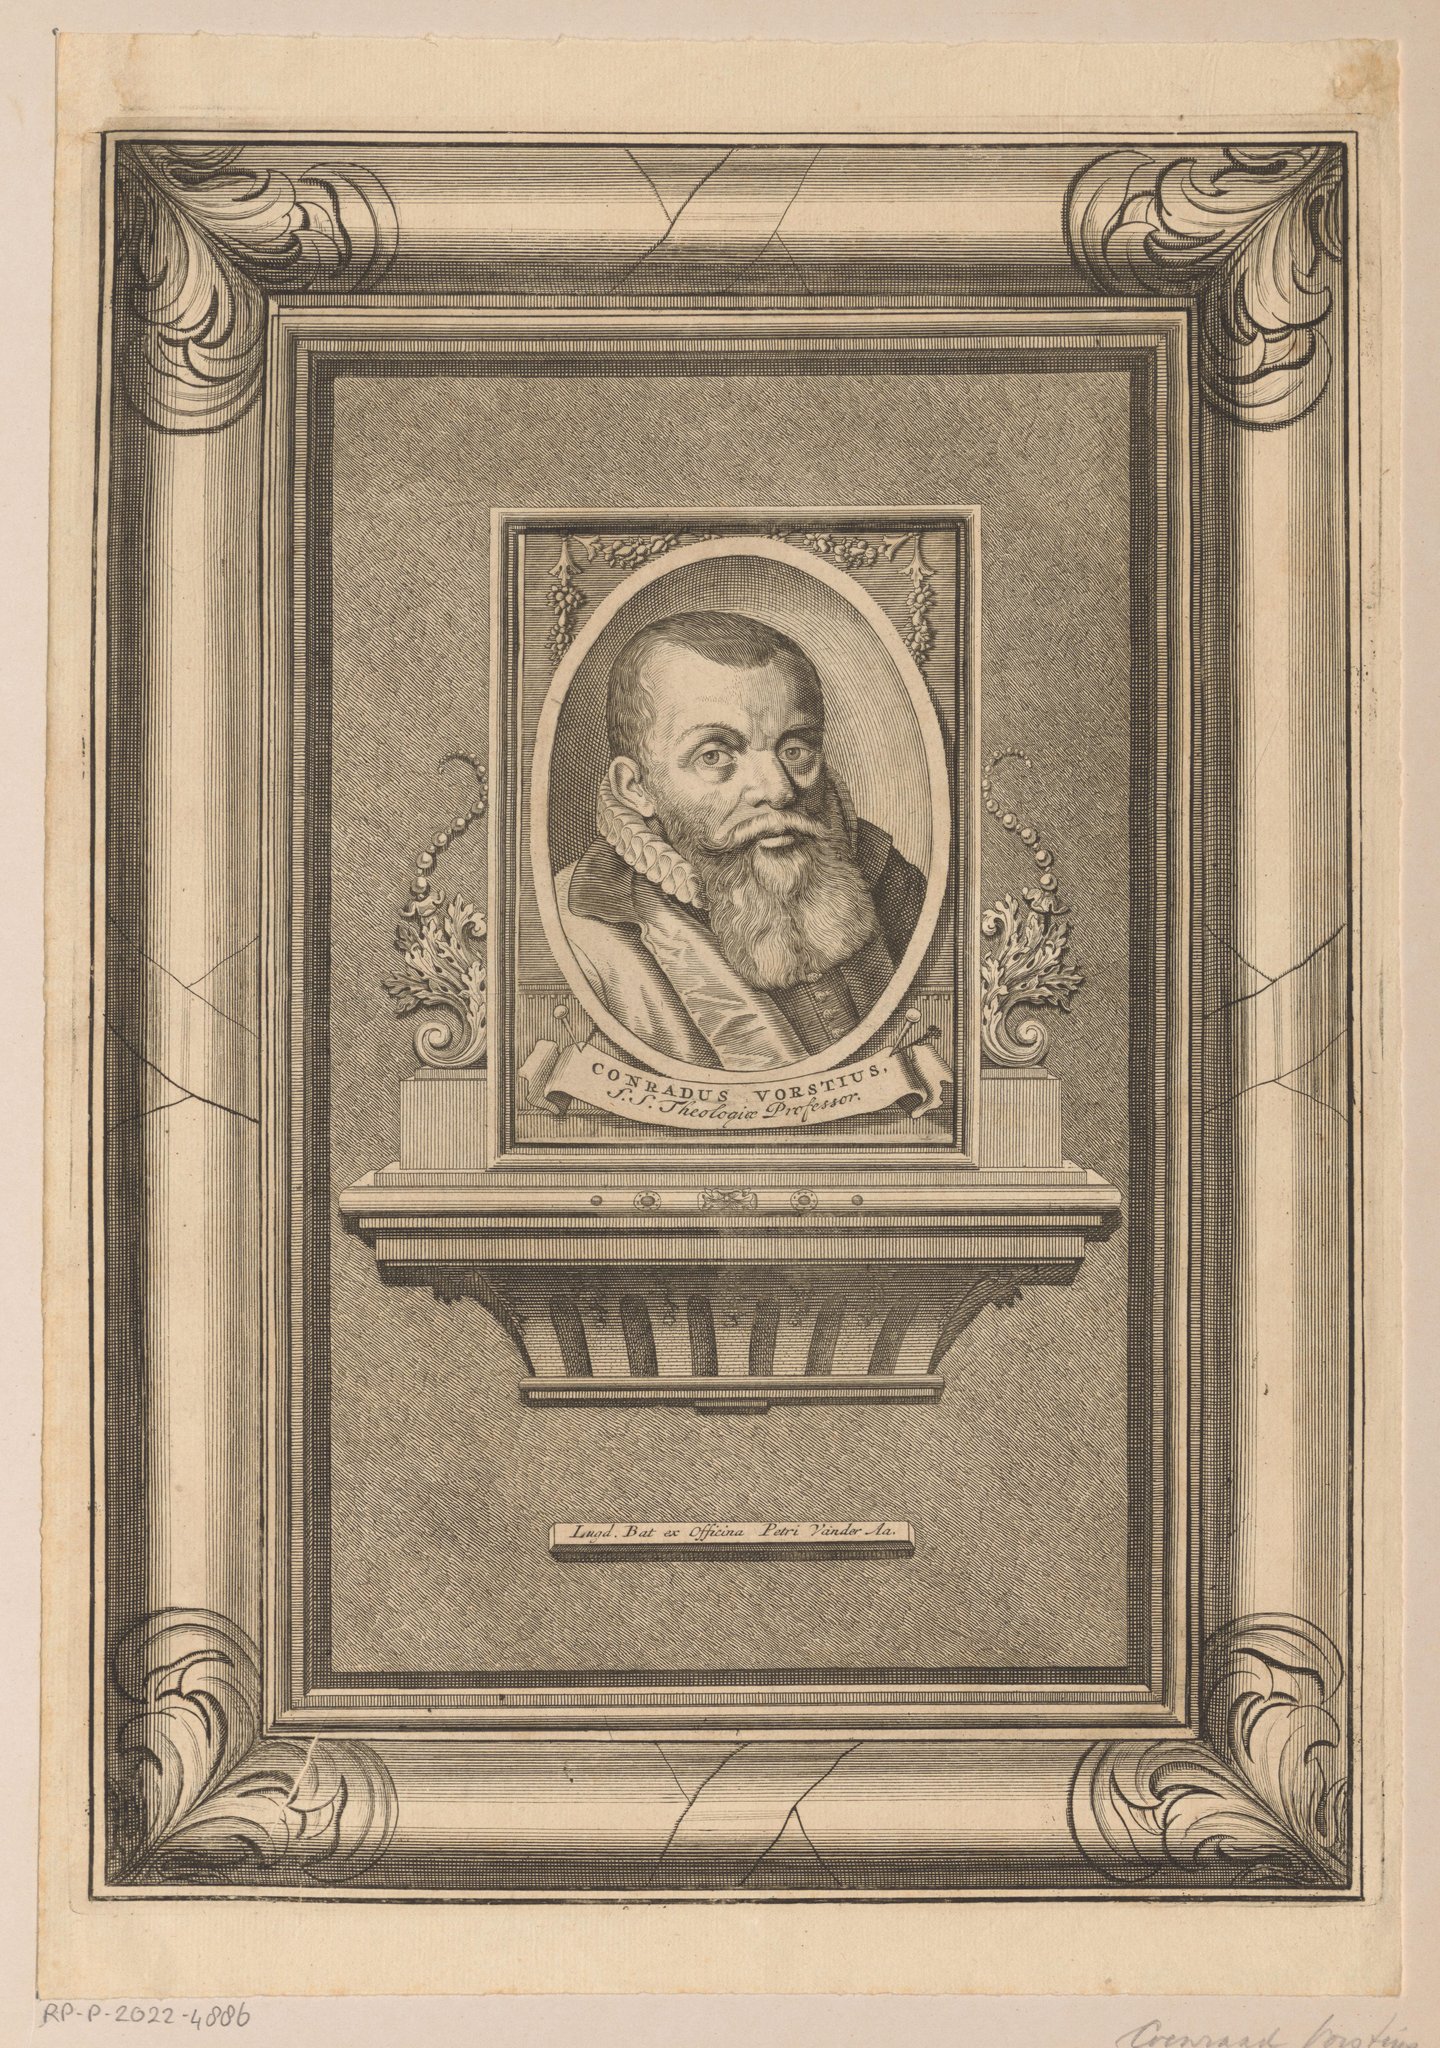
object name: print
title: Fundatoris, curatorum et professorum celeberrimorum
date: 1716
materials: paper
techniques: engraving, etching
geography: leiden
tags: scholar, philosopher, historical persons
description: Met omlijsting gedrukt van twee aparte platen.